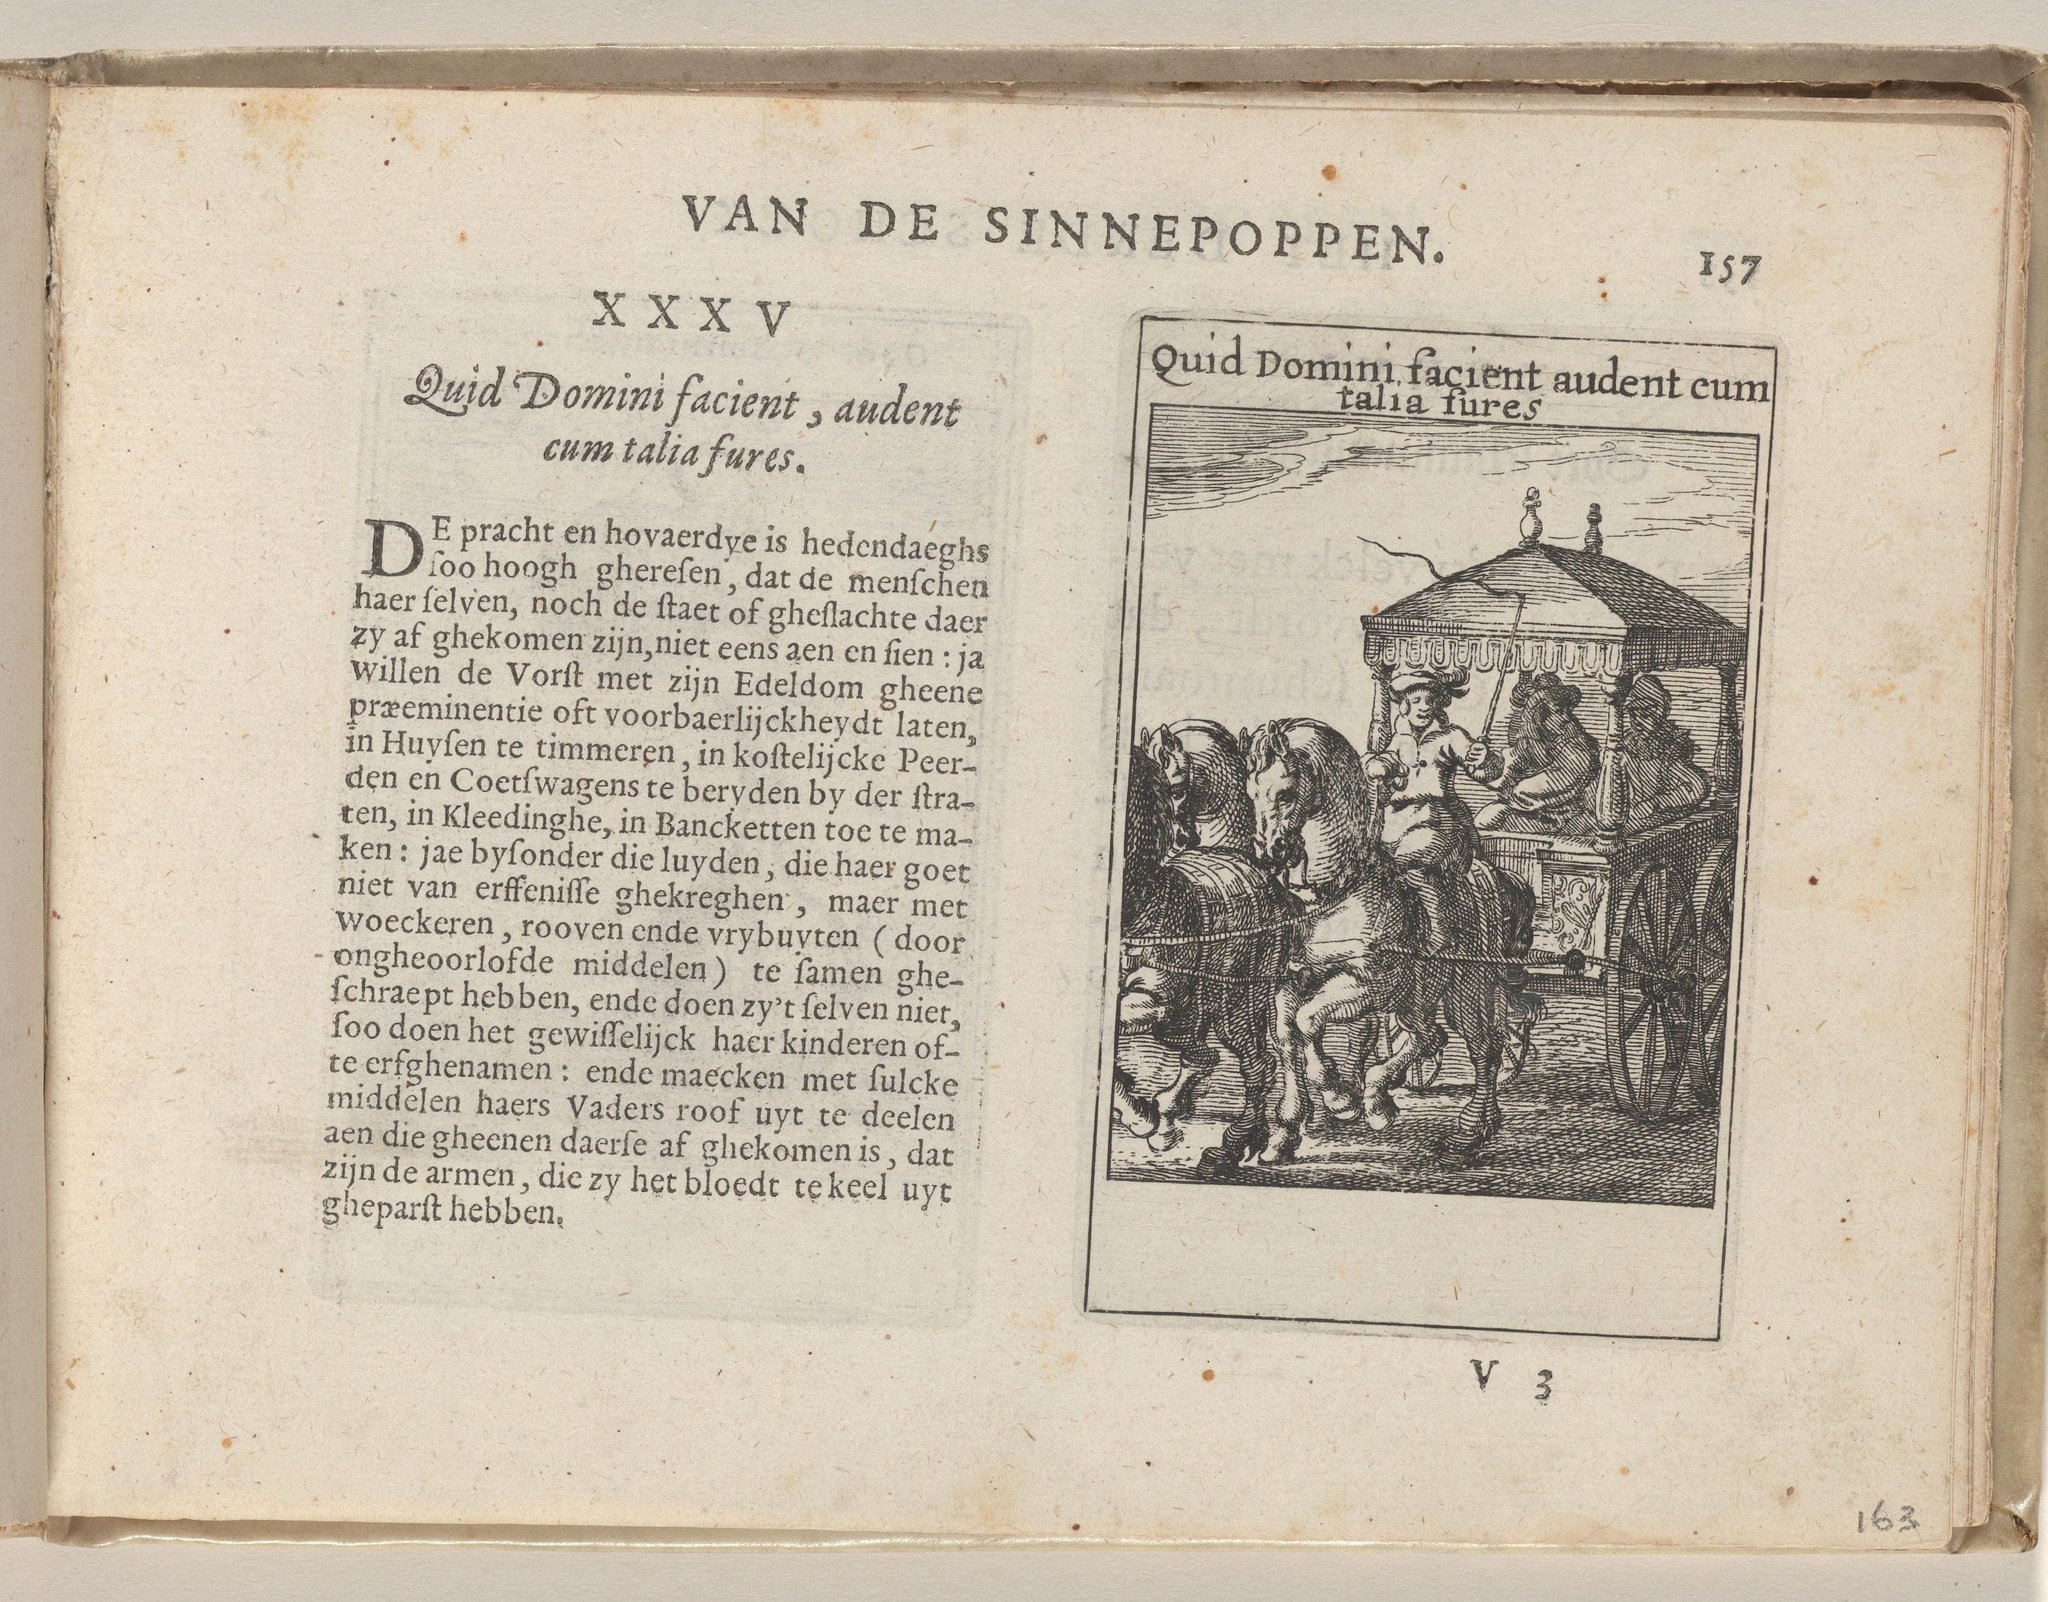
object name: album leaf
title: XXXV Quid Domini facient audent cum talia fures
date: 1614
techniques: engraving, printing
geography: the hague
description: XXXV Quid Domini facient audent cum talia fures. Derde schok. Onderdeel van 'Sinnepoppen', R. Visscher, 1614.